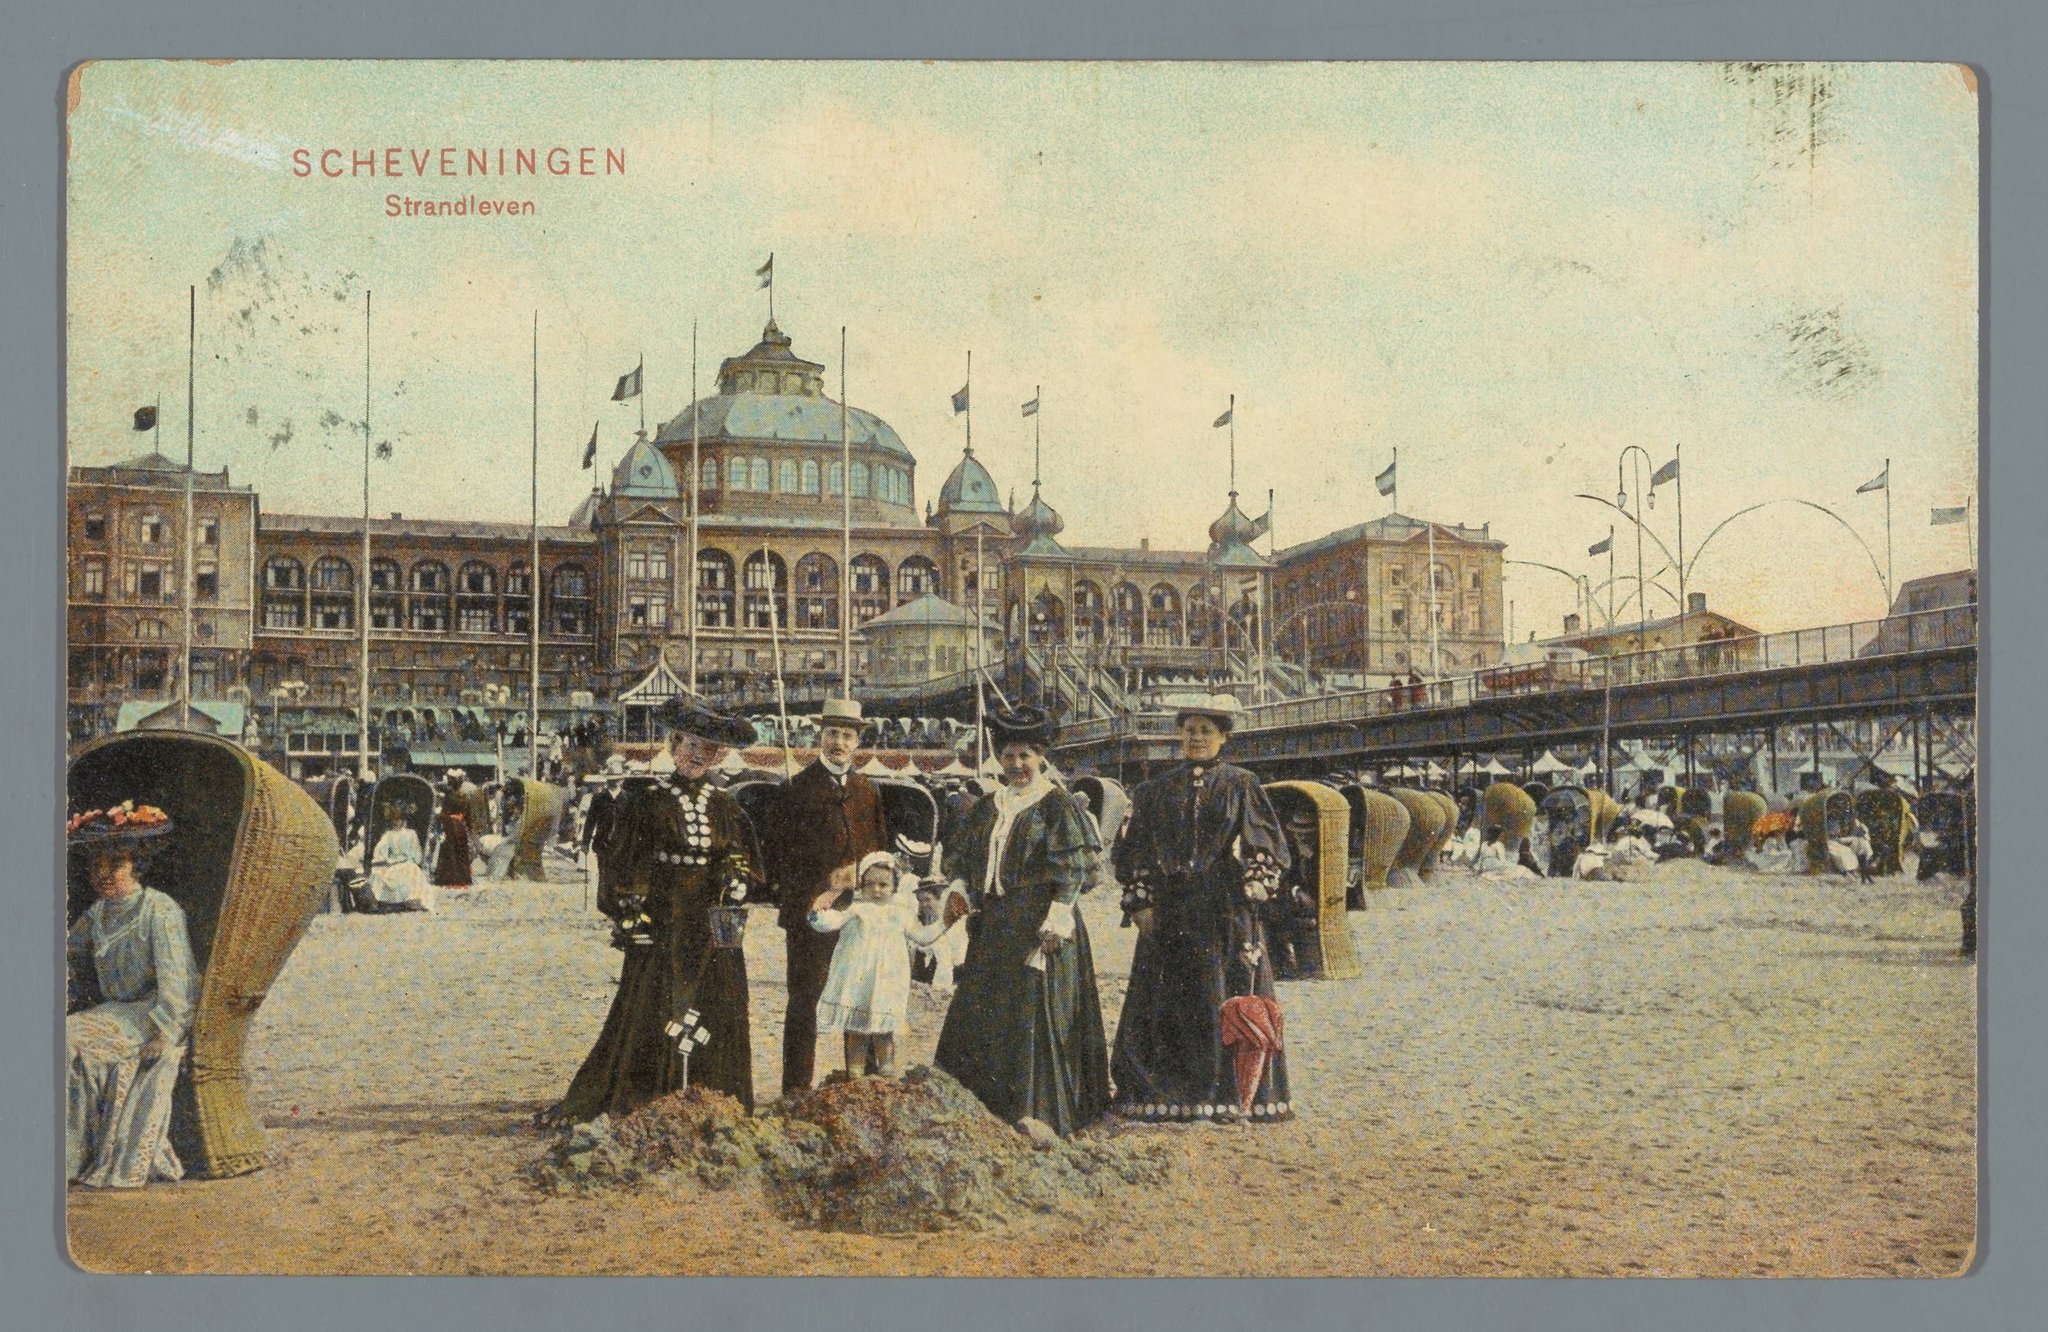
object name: photomechanical print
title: Scheveningen, Strandleven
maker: Anonymous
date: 1906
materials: cardboard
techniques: writing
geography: scheveningen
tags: beach